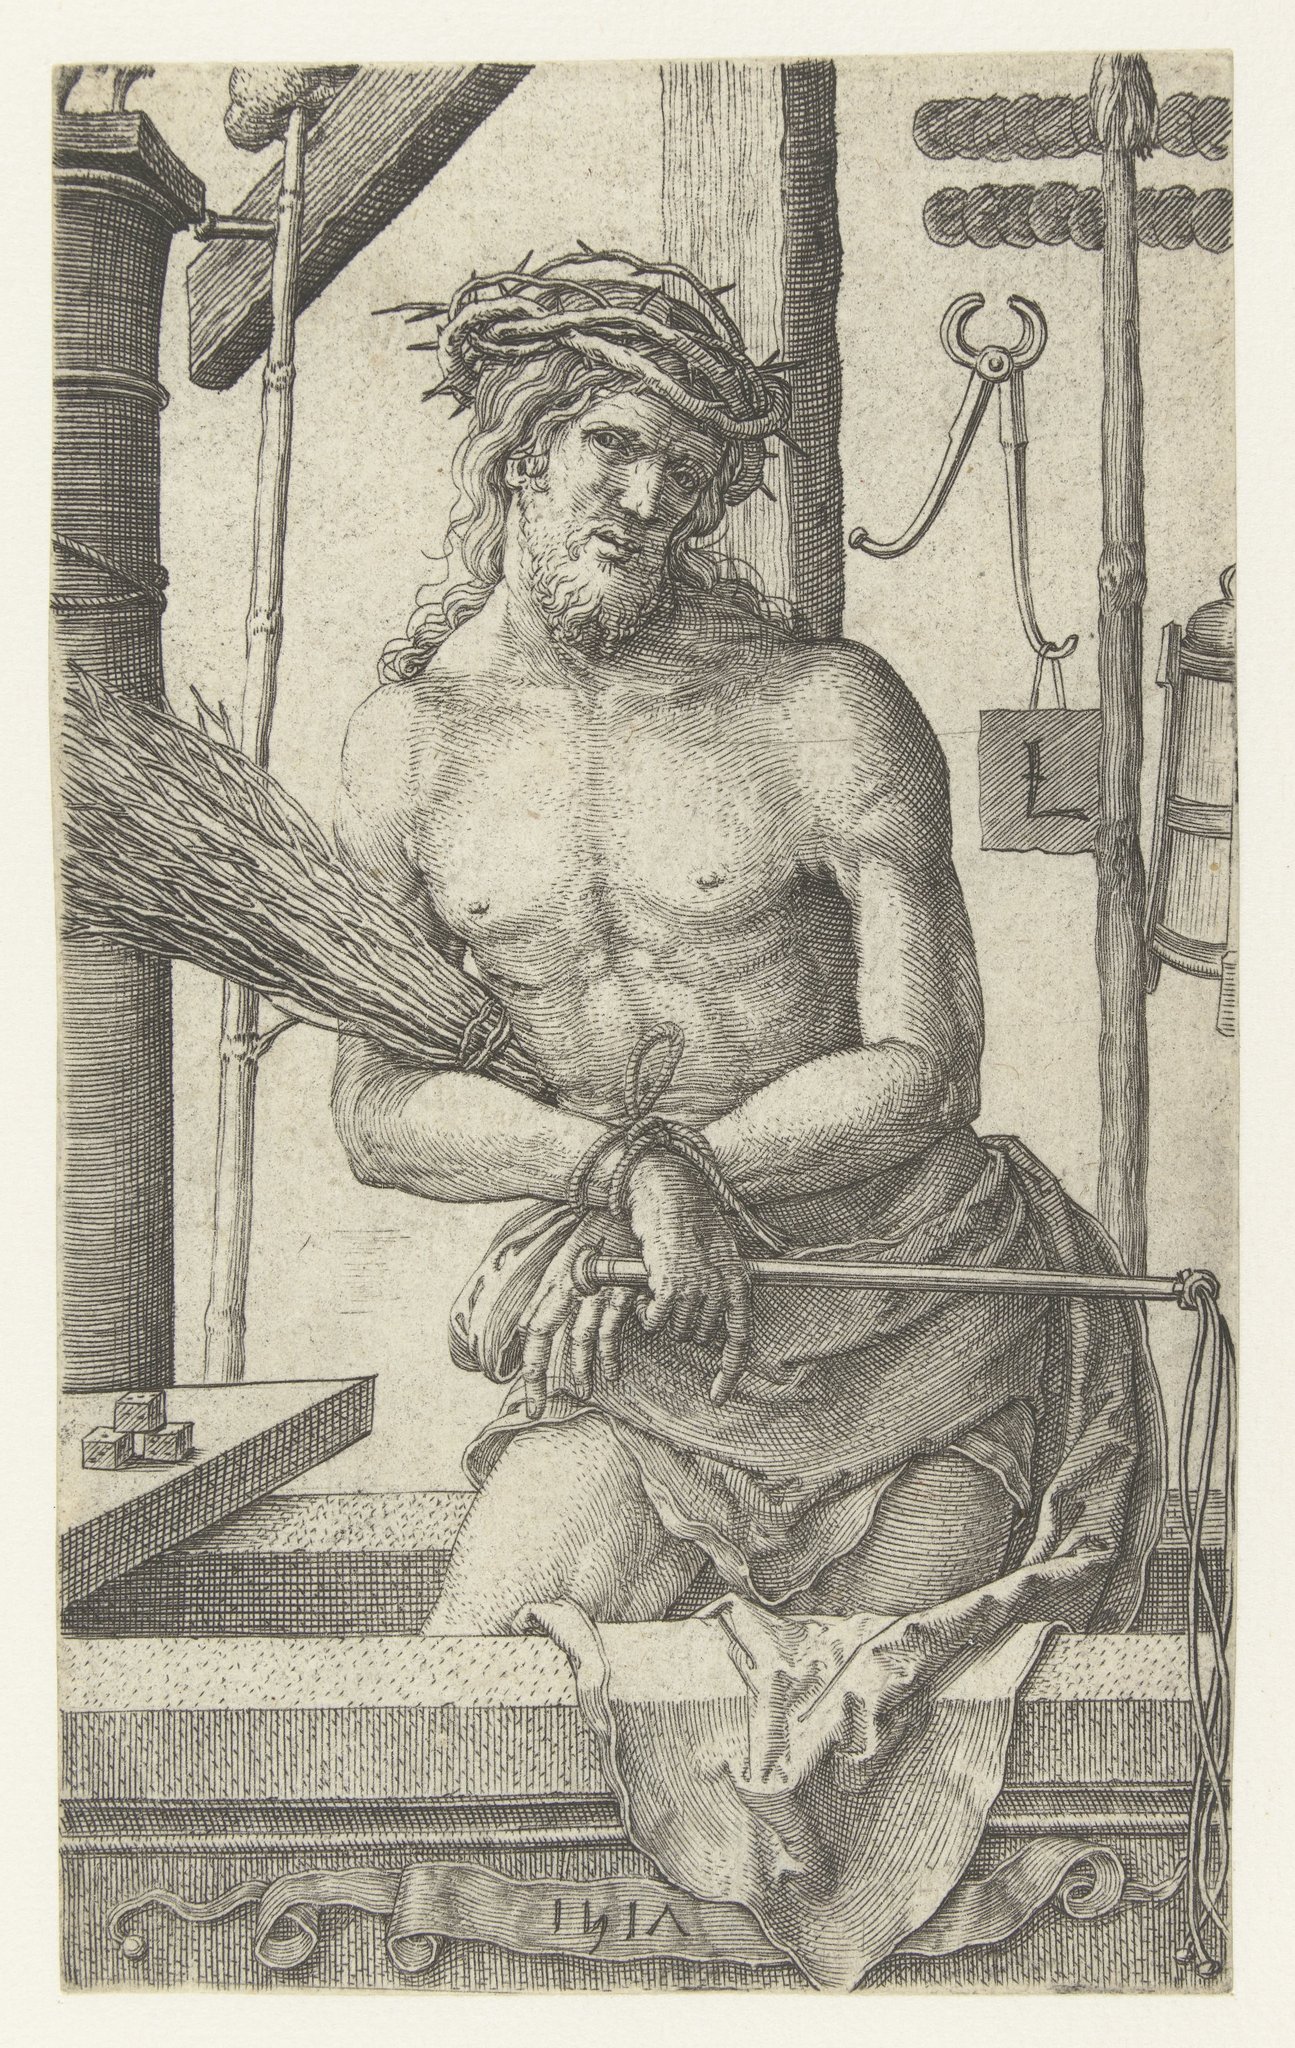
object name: print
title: Man van Smarten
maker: lucas van leyden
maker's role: draughtsman, painter, print maker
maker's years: 1494-1533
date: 1517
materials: paper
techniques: engraving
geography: low countries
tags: man of sorrows, 'imago pietatis', 'erbärmdebild', 'schmerzensmann'; the upright christ showing his wounds, usually bearing the crown of thorns, and accompanied by the instruments of the passion, standing or sitting in his tomb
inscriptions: collector's mark: Lugt 240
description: Christus als Man van Smarten, staand in graftombe, om hem heen passiewerktuigen.